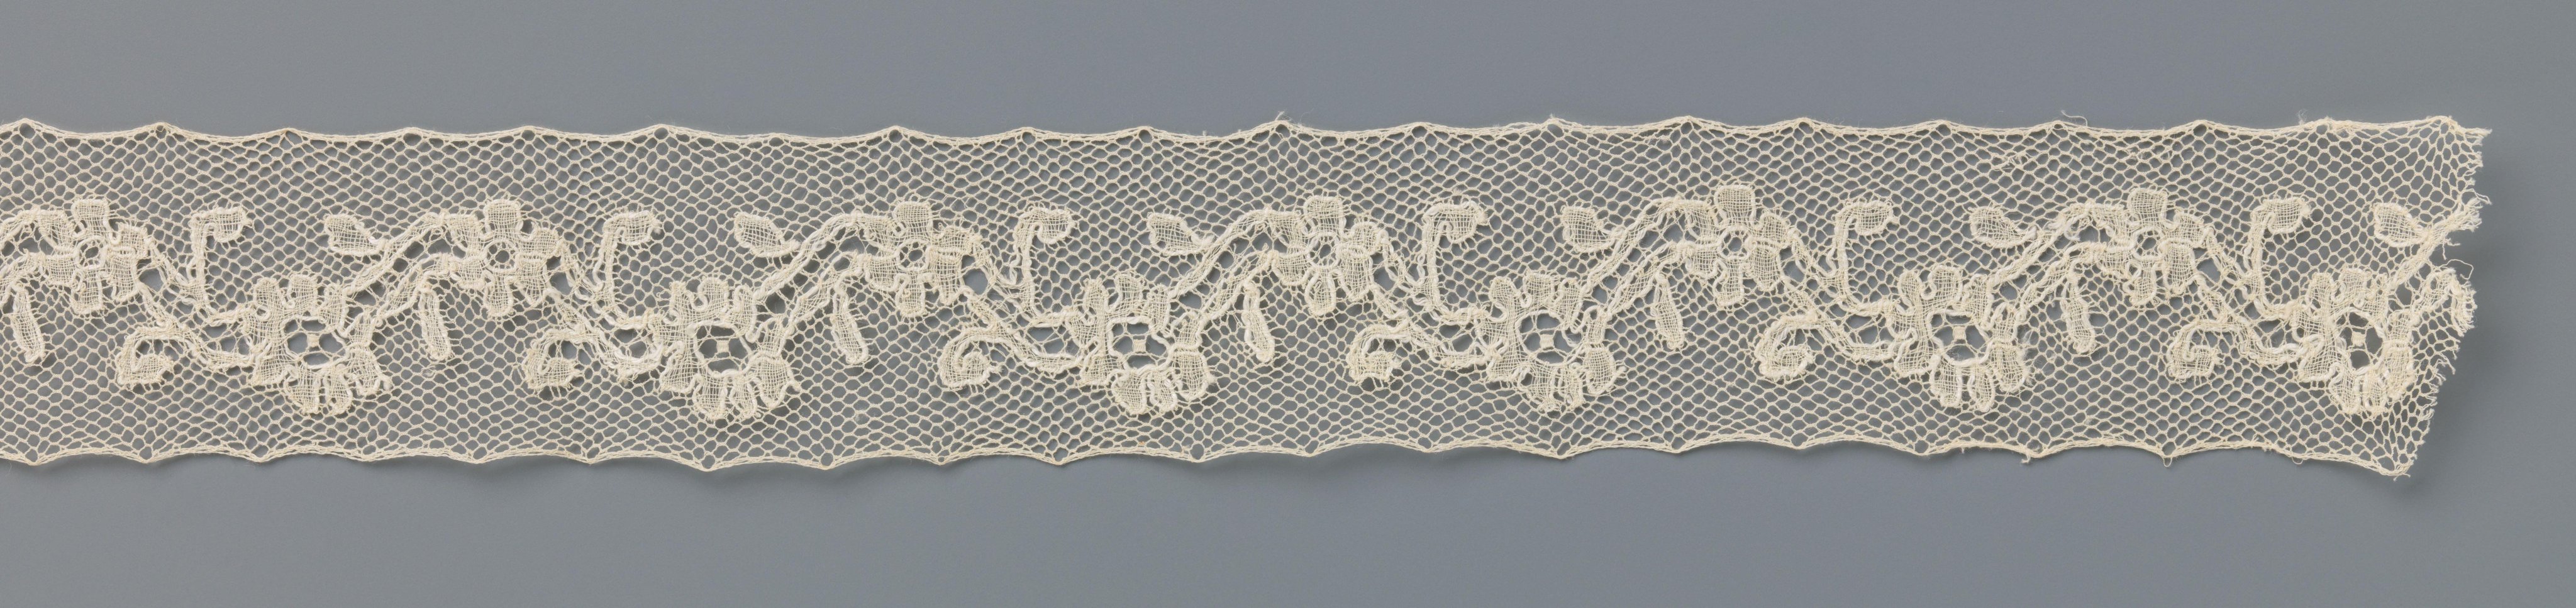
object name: strip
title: Tussenzetsel van kloskant met zigzaglijn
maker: Anonymous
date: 1875-1949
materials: linen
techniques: lace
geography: belgium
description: Tussenzetsel van naturelkleurige kloskant: Mechelse kant. In het midden van de fijne traliegrond, een Mechelse grond (ook wel ijsgrond genoemd), loopt een opengewerkte band in zigzaglijn, oversneden door twee soorten rozetjes.